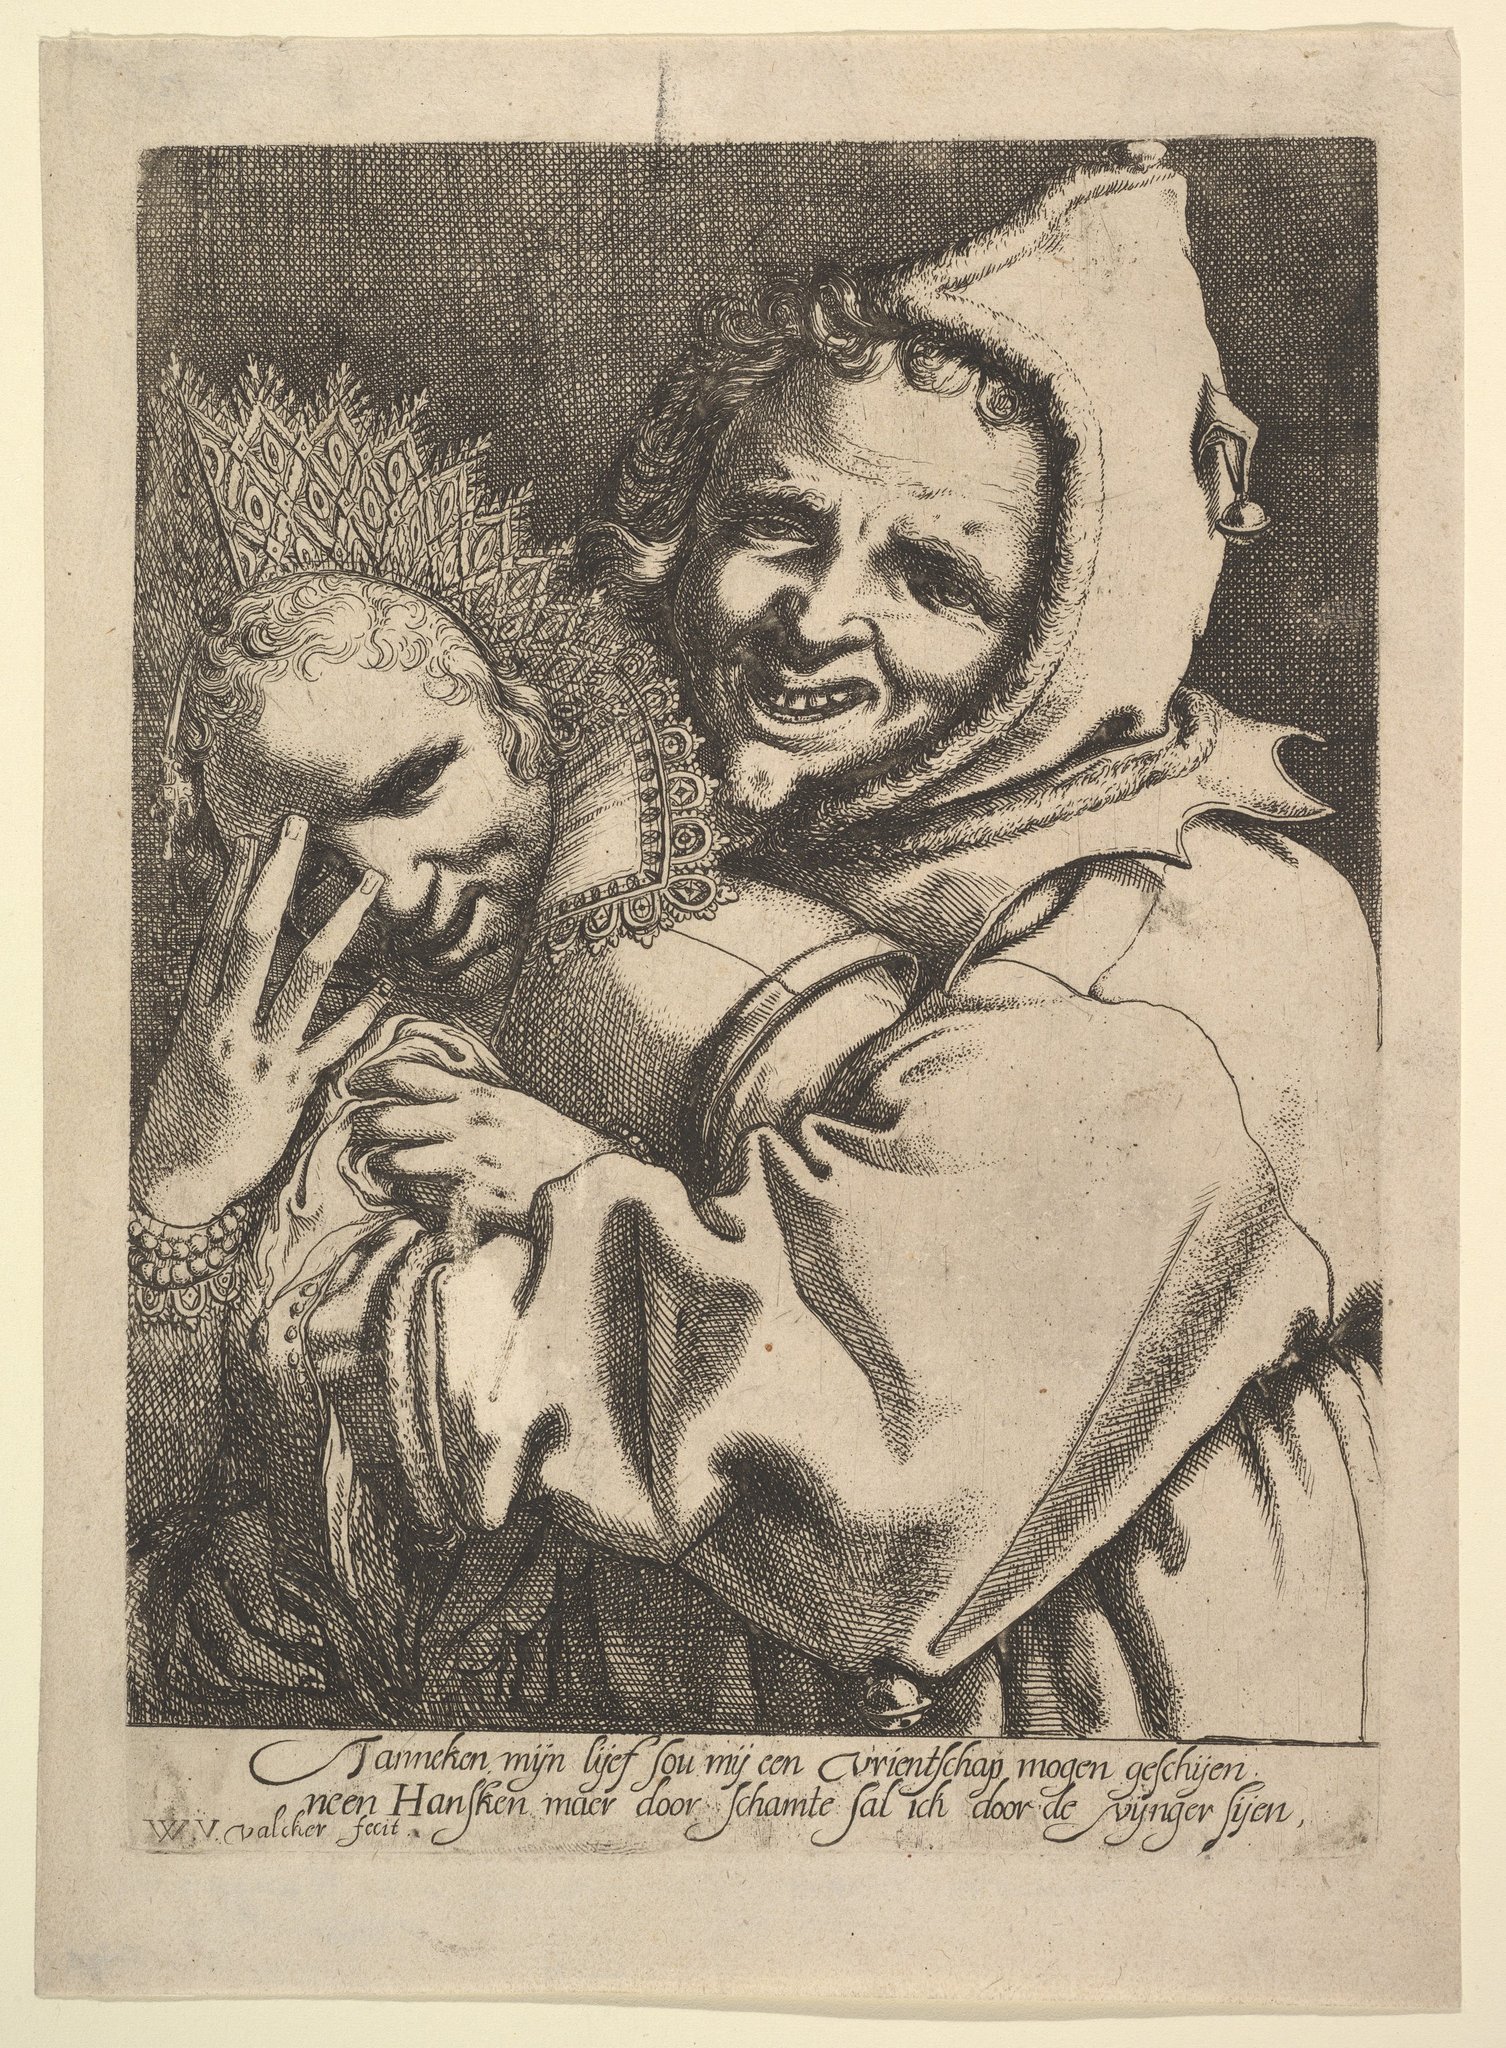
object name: print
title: Fool with a Girl Looking Through Her Fingers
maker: werner van den valckert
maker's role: artist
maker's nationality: dutch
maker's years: 1580-1627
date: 1610-1620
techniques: engraving, etching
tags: girls,men,portraits